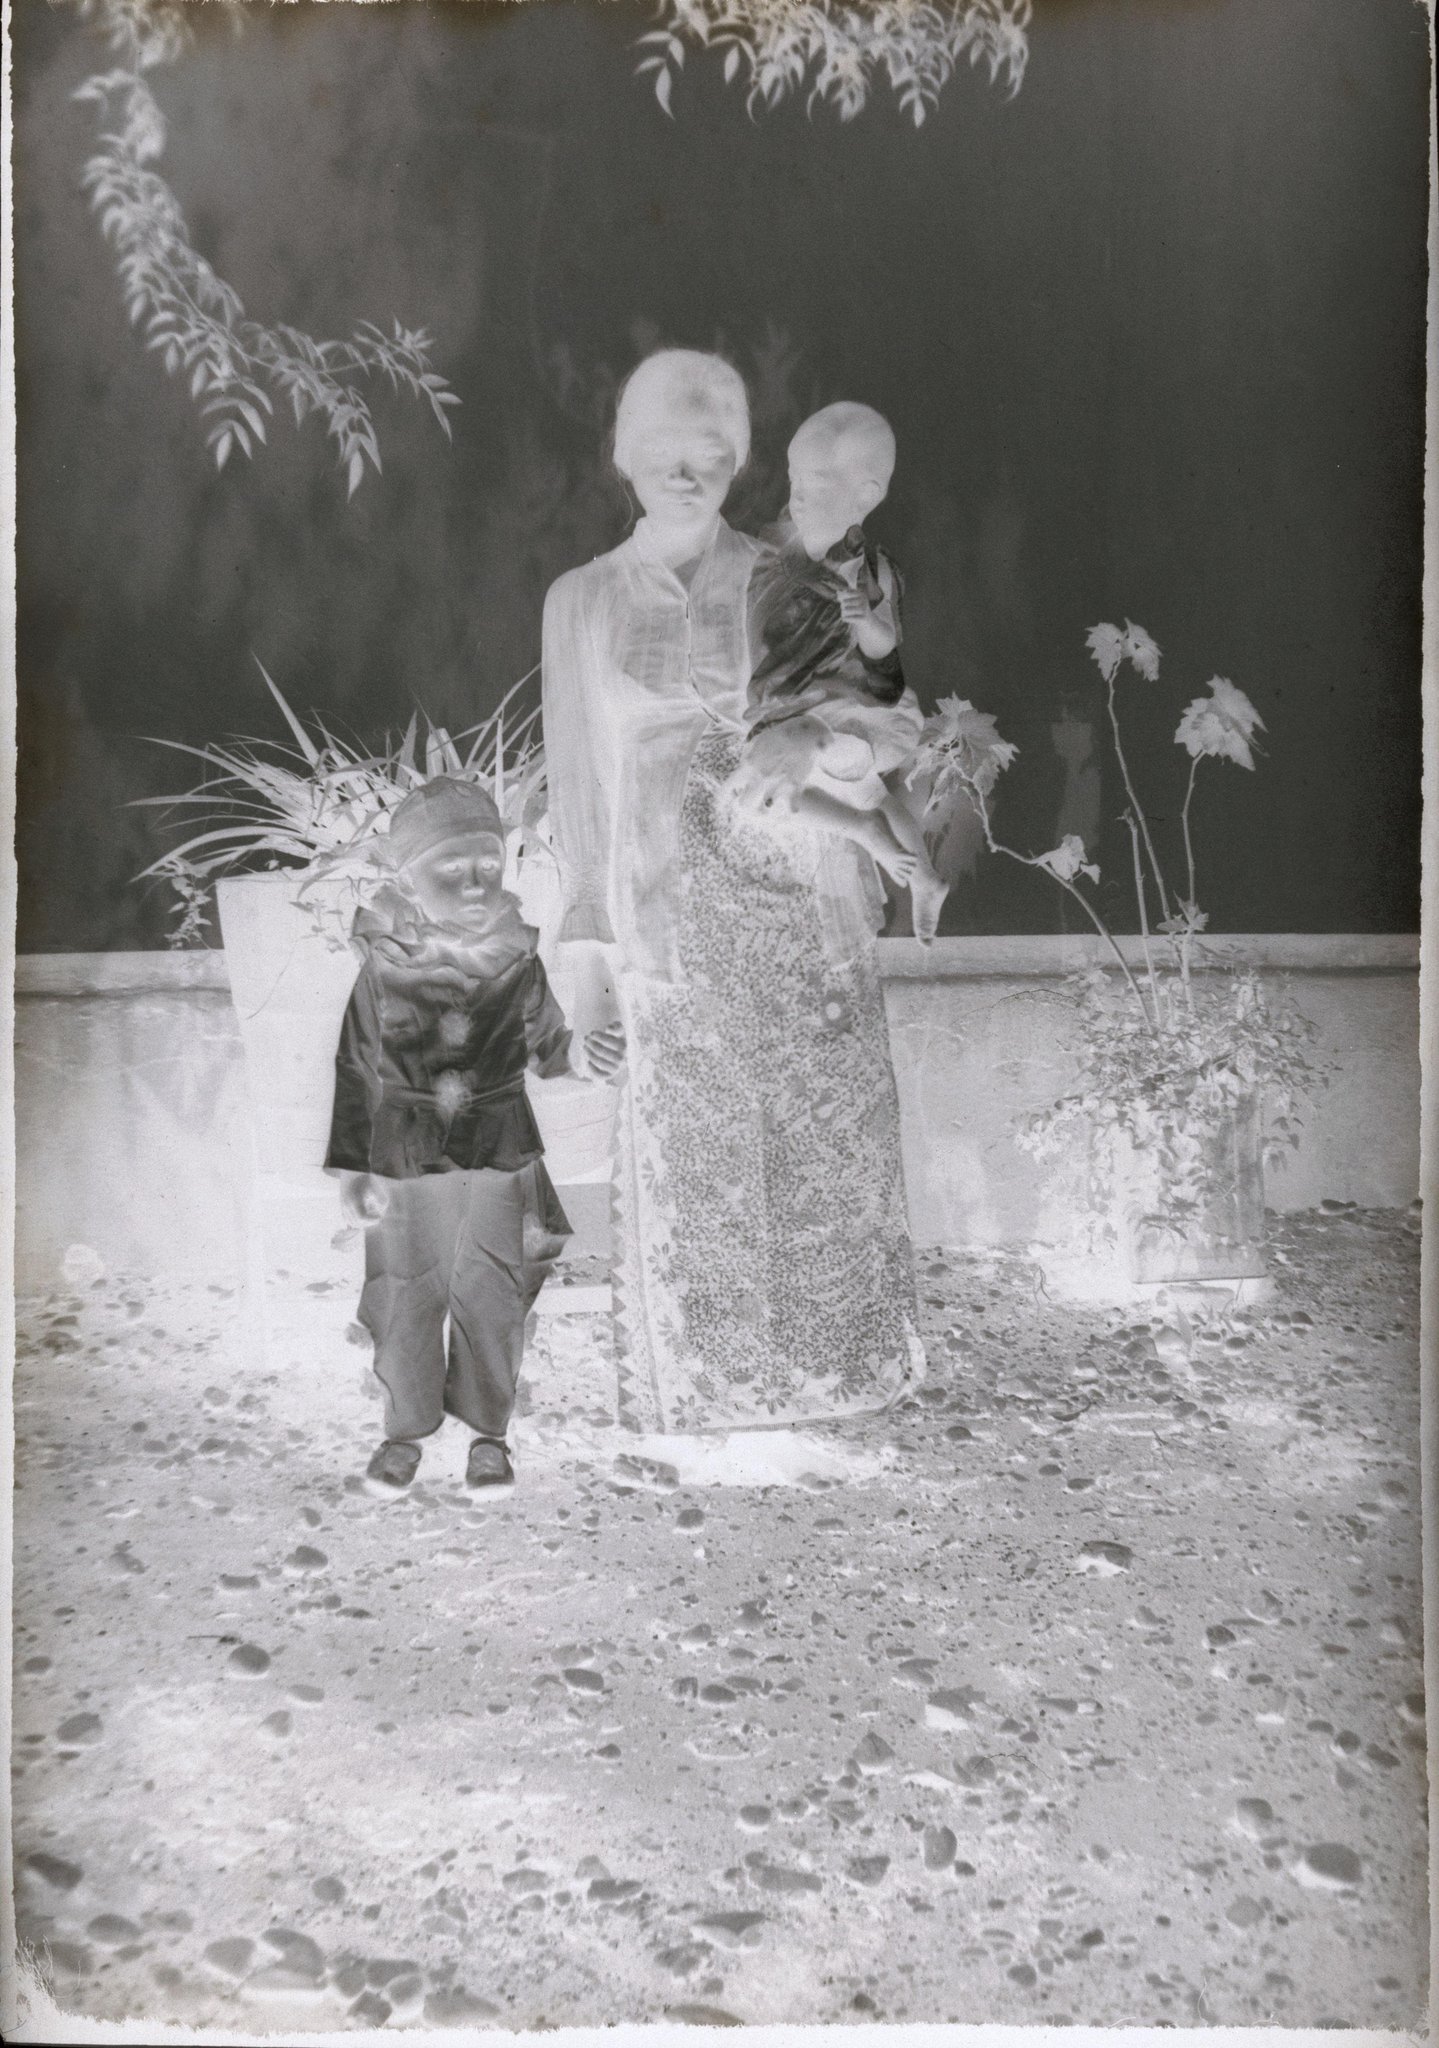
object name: negative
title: Indonesisch kindermeisje (destijds 'baboe' genoemd) met twee kinderen (Pitteke en Fritsje), waarvan één (Pitteke) verkleed als pierrot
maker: Anonymous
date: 1928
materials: film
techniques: gelatin silver negative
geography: dutch east indies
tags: types in 'commedia dell'arte': pierrot, baby-sitter, house personnel, servants, dutch east indies, the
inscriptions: number: ‘15’, number: ‘5’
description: Onderdeel van Kodak negatievenalbum met 35 foto's van een familie in Nederlands-Indië.